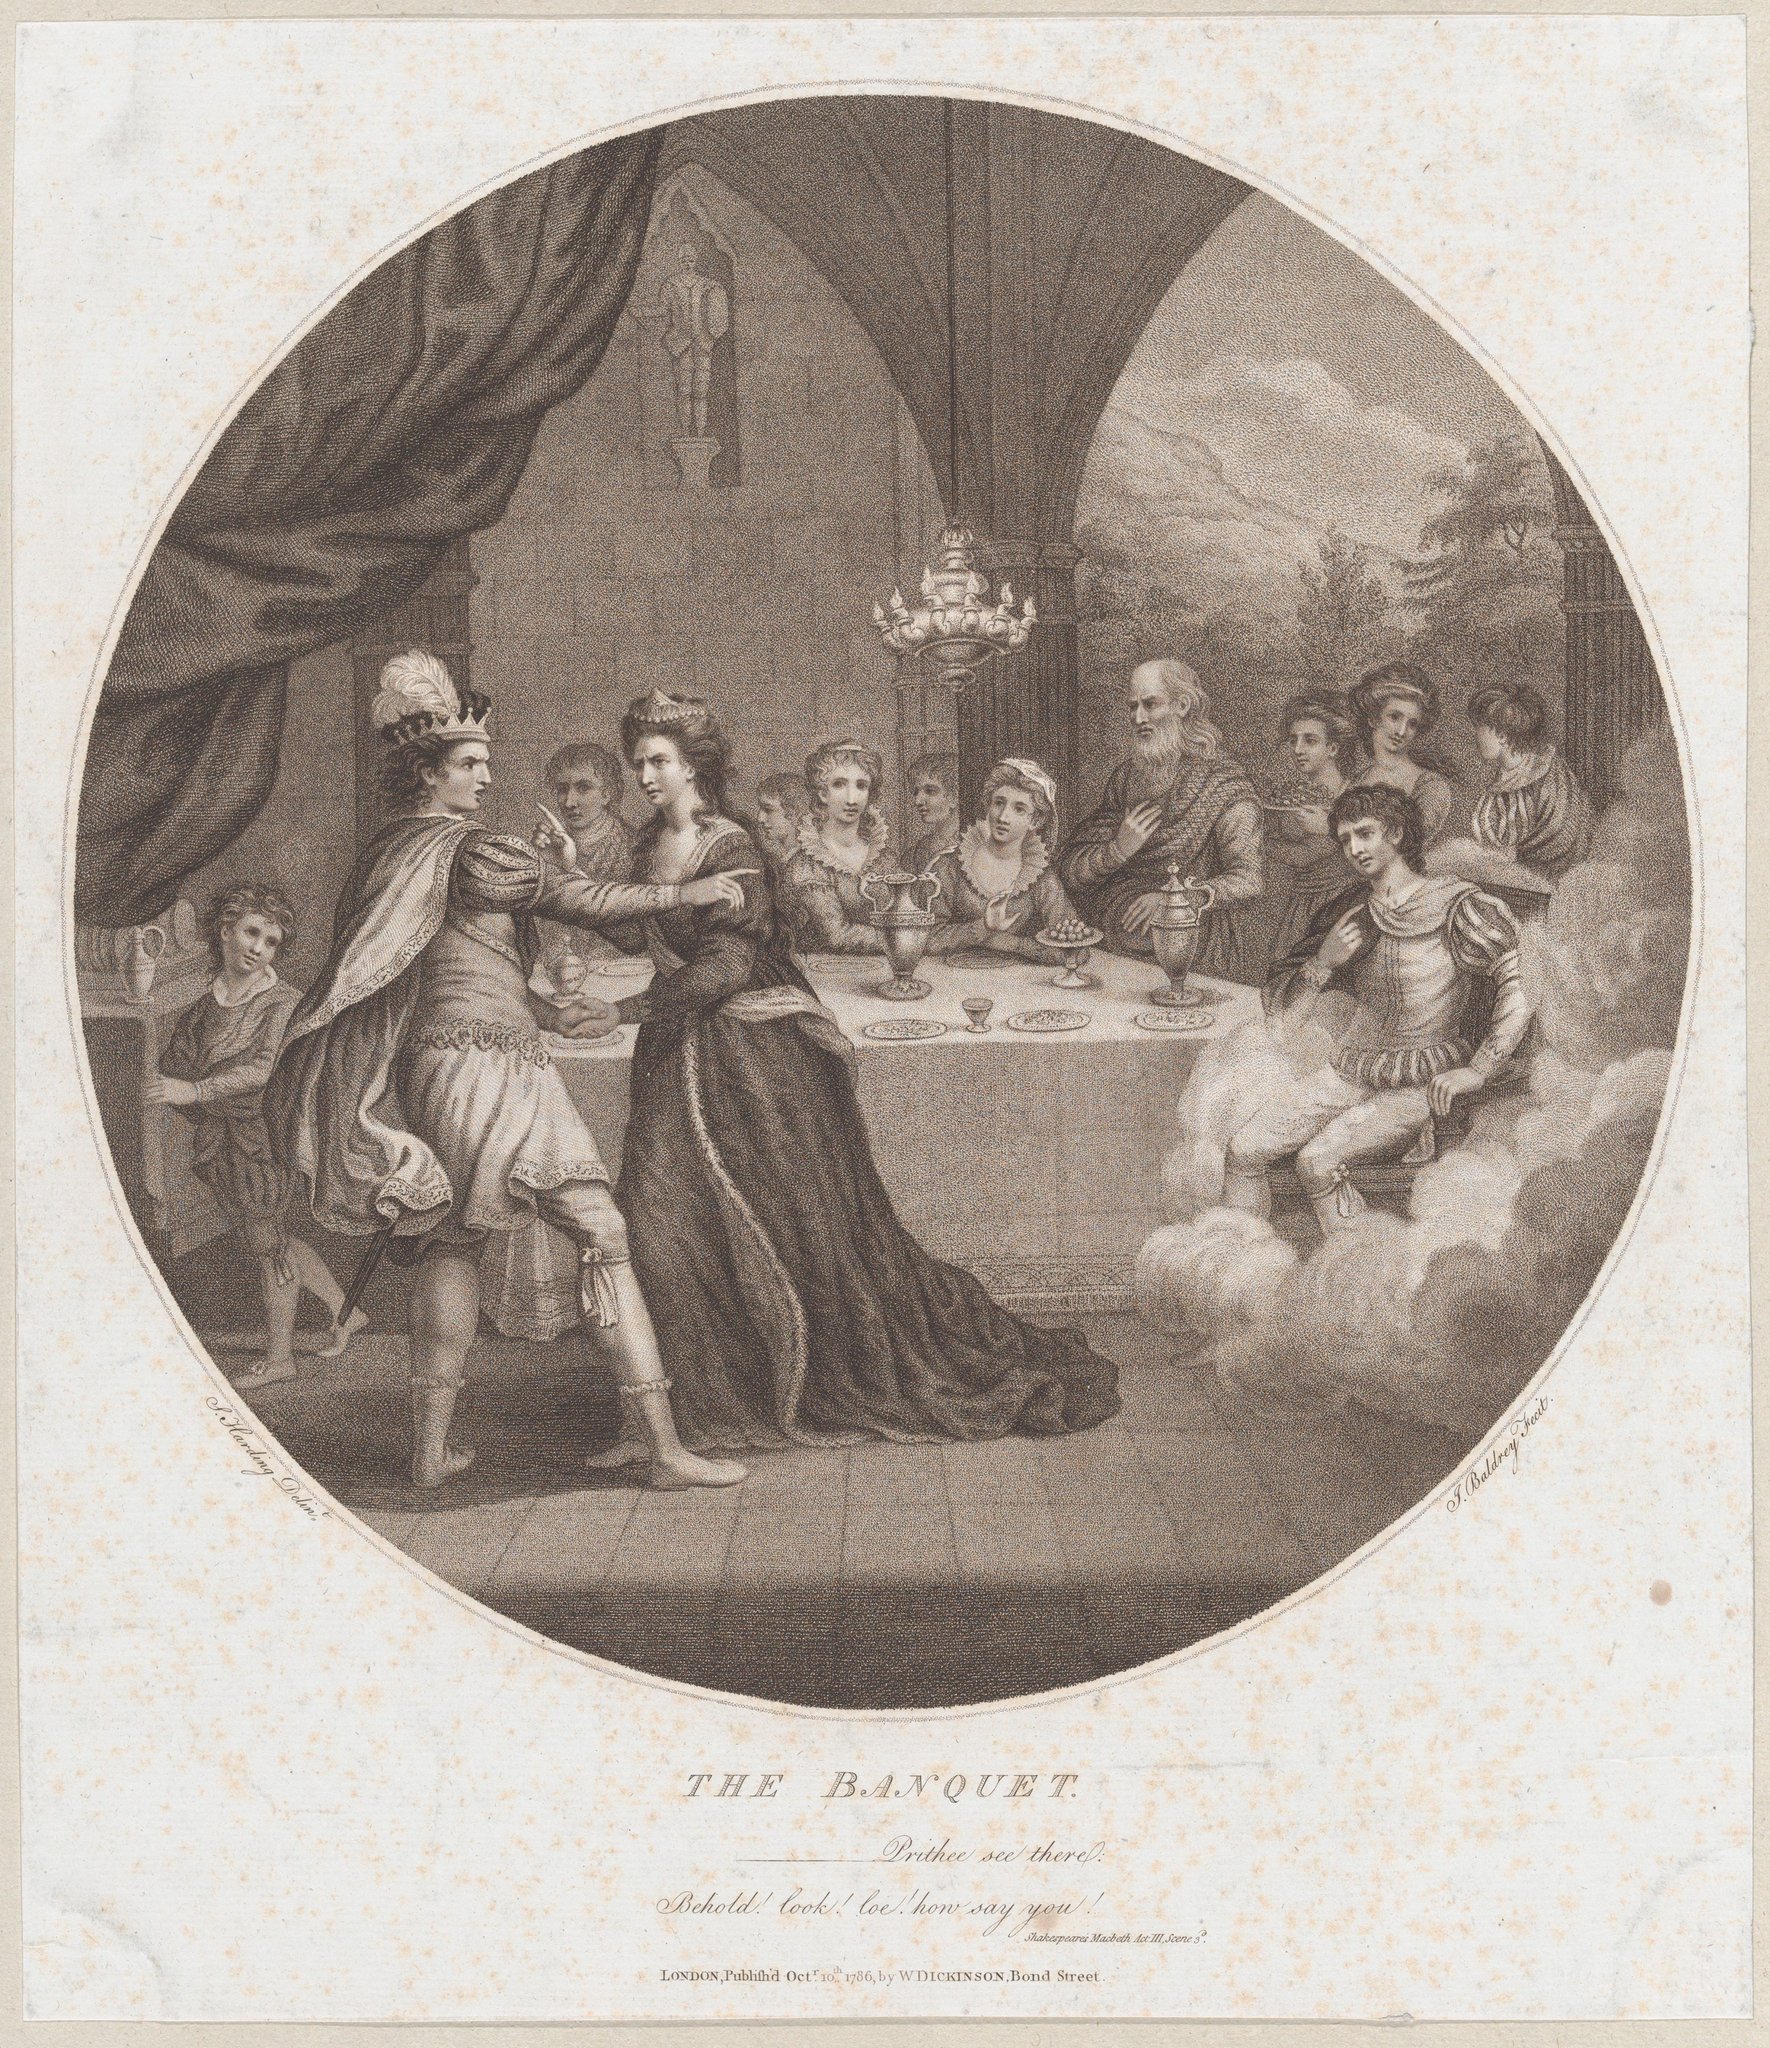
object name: print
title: The Banquet (Shakespeare, Macbeth, Act 3, Scene 3)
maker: john baldrey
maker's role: engraver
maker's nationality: british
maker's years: 1758-1792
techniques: engraving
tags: shakespeare,boys,girls,men,women,tables,banquets